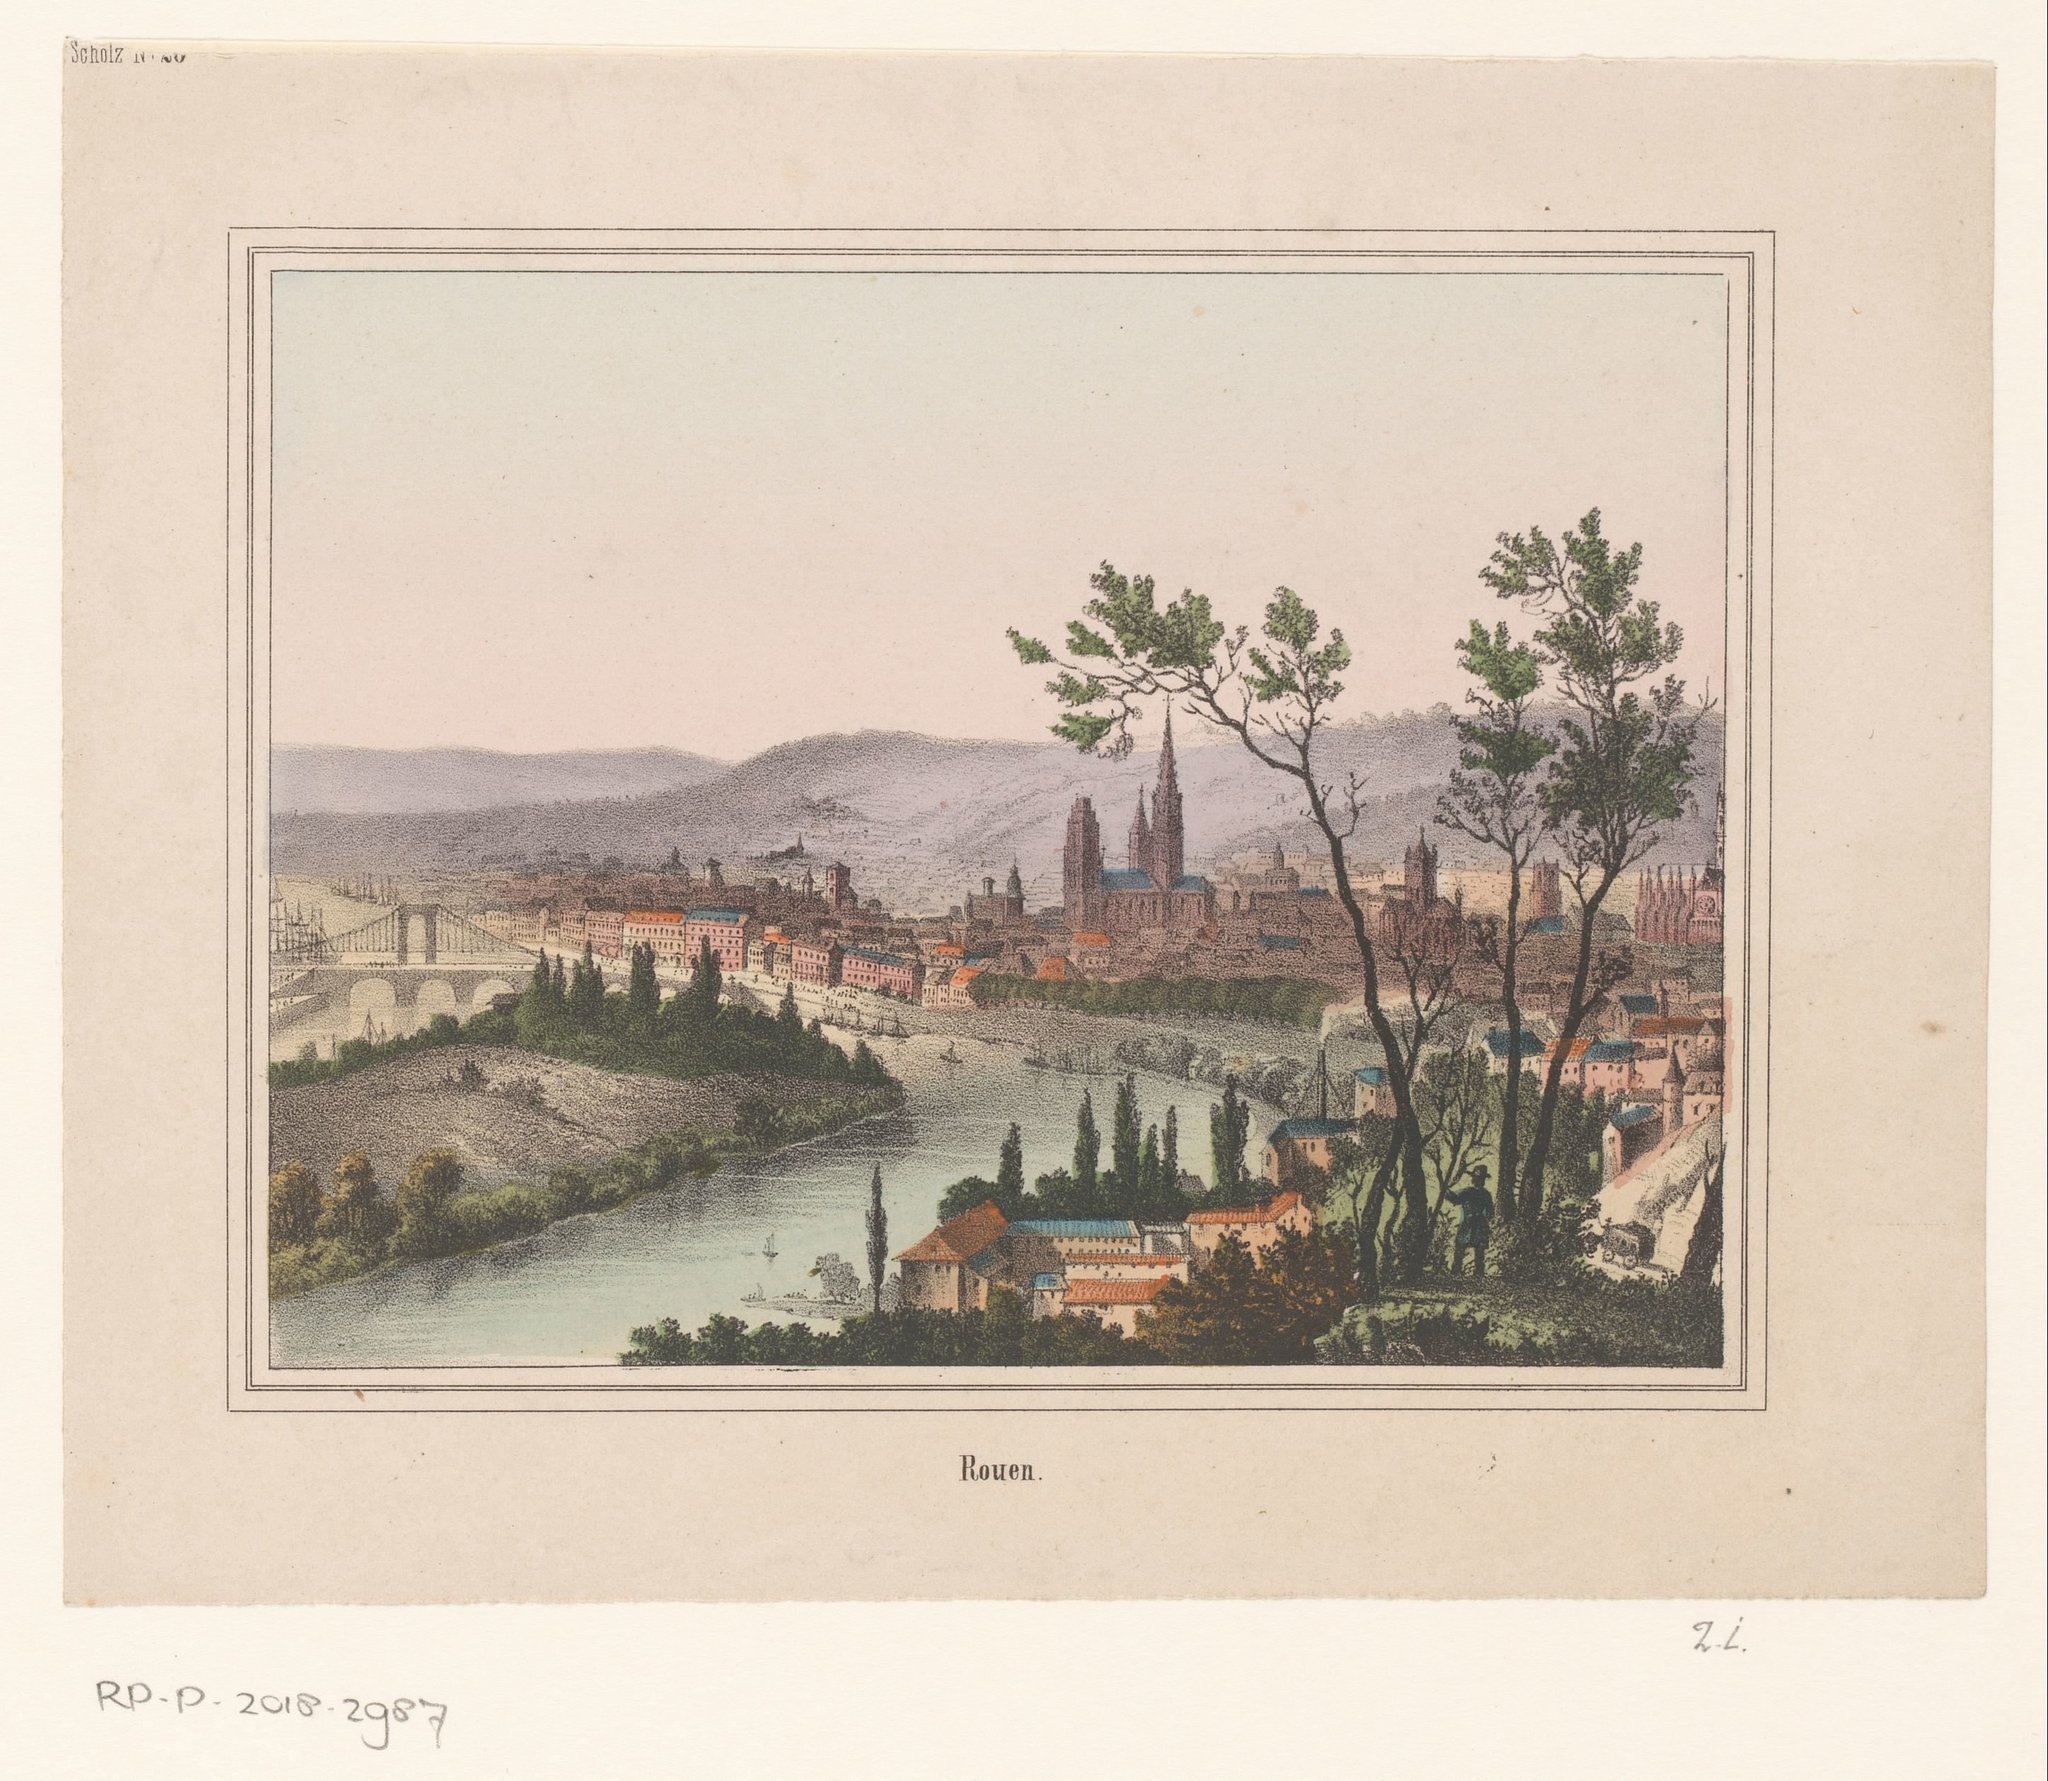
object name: print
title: Gezicht op Rouen en de Seine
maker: Anonymous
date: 1829-1880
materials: paper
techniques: hand coloring, lithograph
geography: mainz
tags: river, prospect of city, town panorama, silhouette of city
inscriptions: collector's mark: Lugt 2228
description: Mogelijk uitgegeven door Scholz (Mainz), gezien de gedrukte aantekening Scholz no. 2[.] in de bovenmarge.